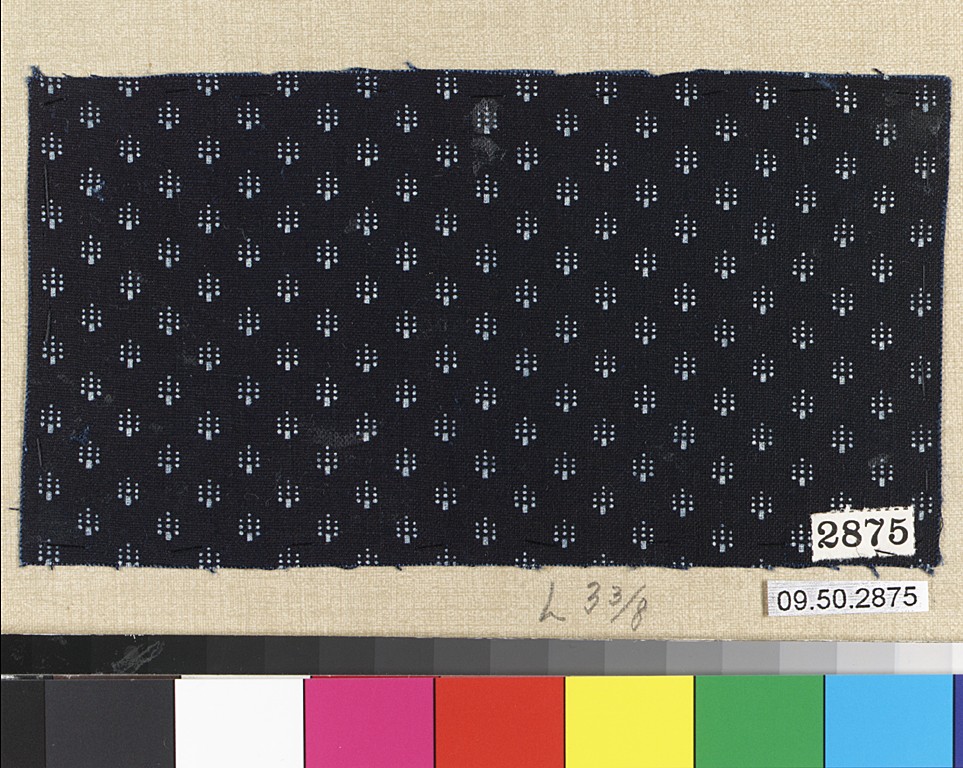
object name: piece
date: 1801-1900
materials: cotton